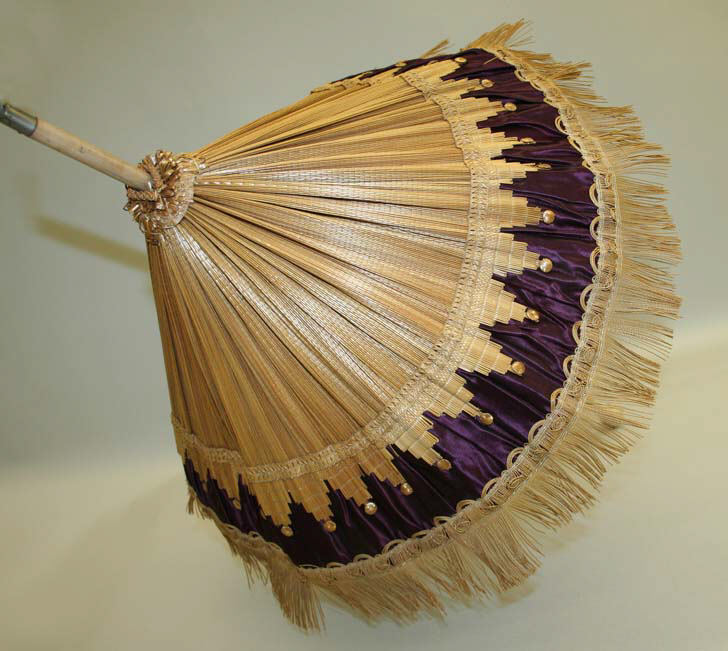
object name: parasol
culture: american or european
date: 1801-1900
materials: silk, fiber